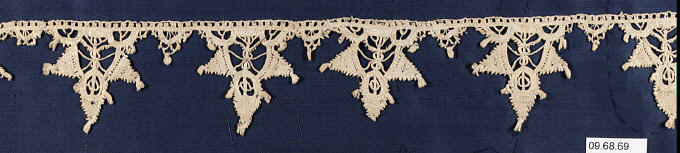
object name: border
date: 1600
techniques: lace